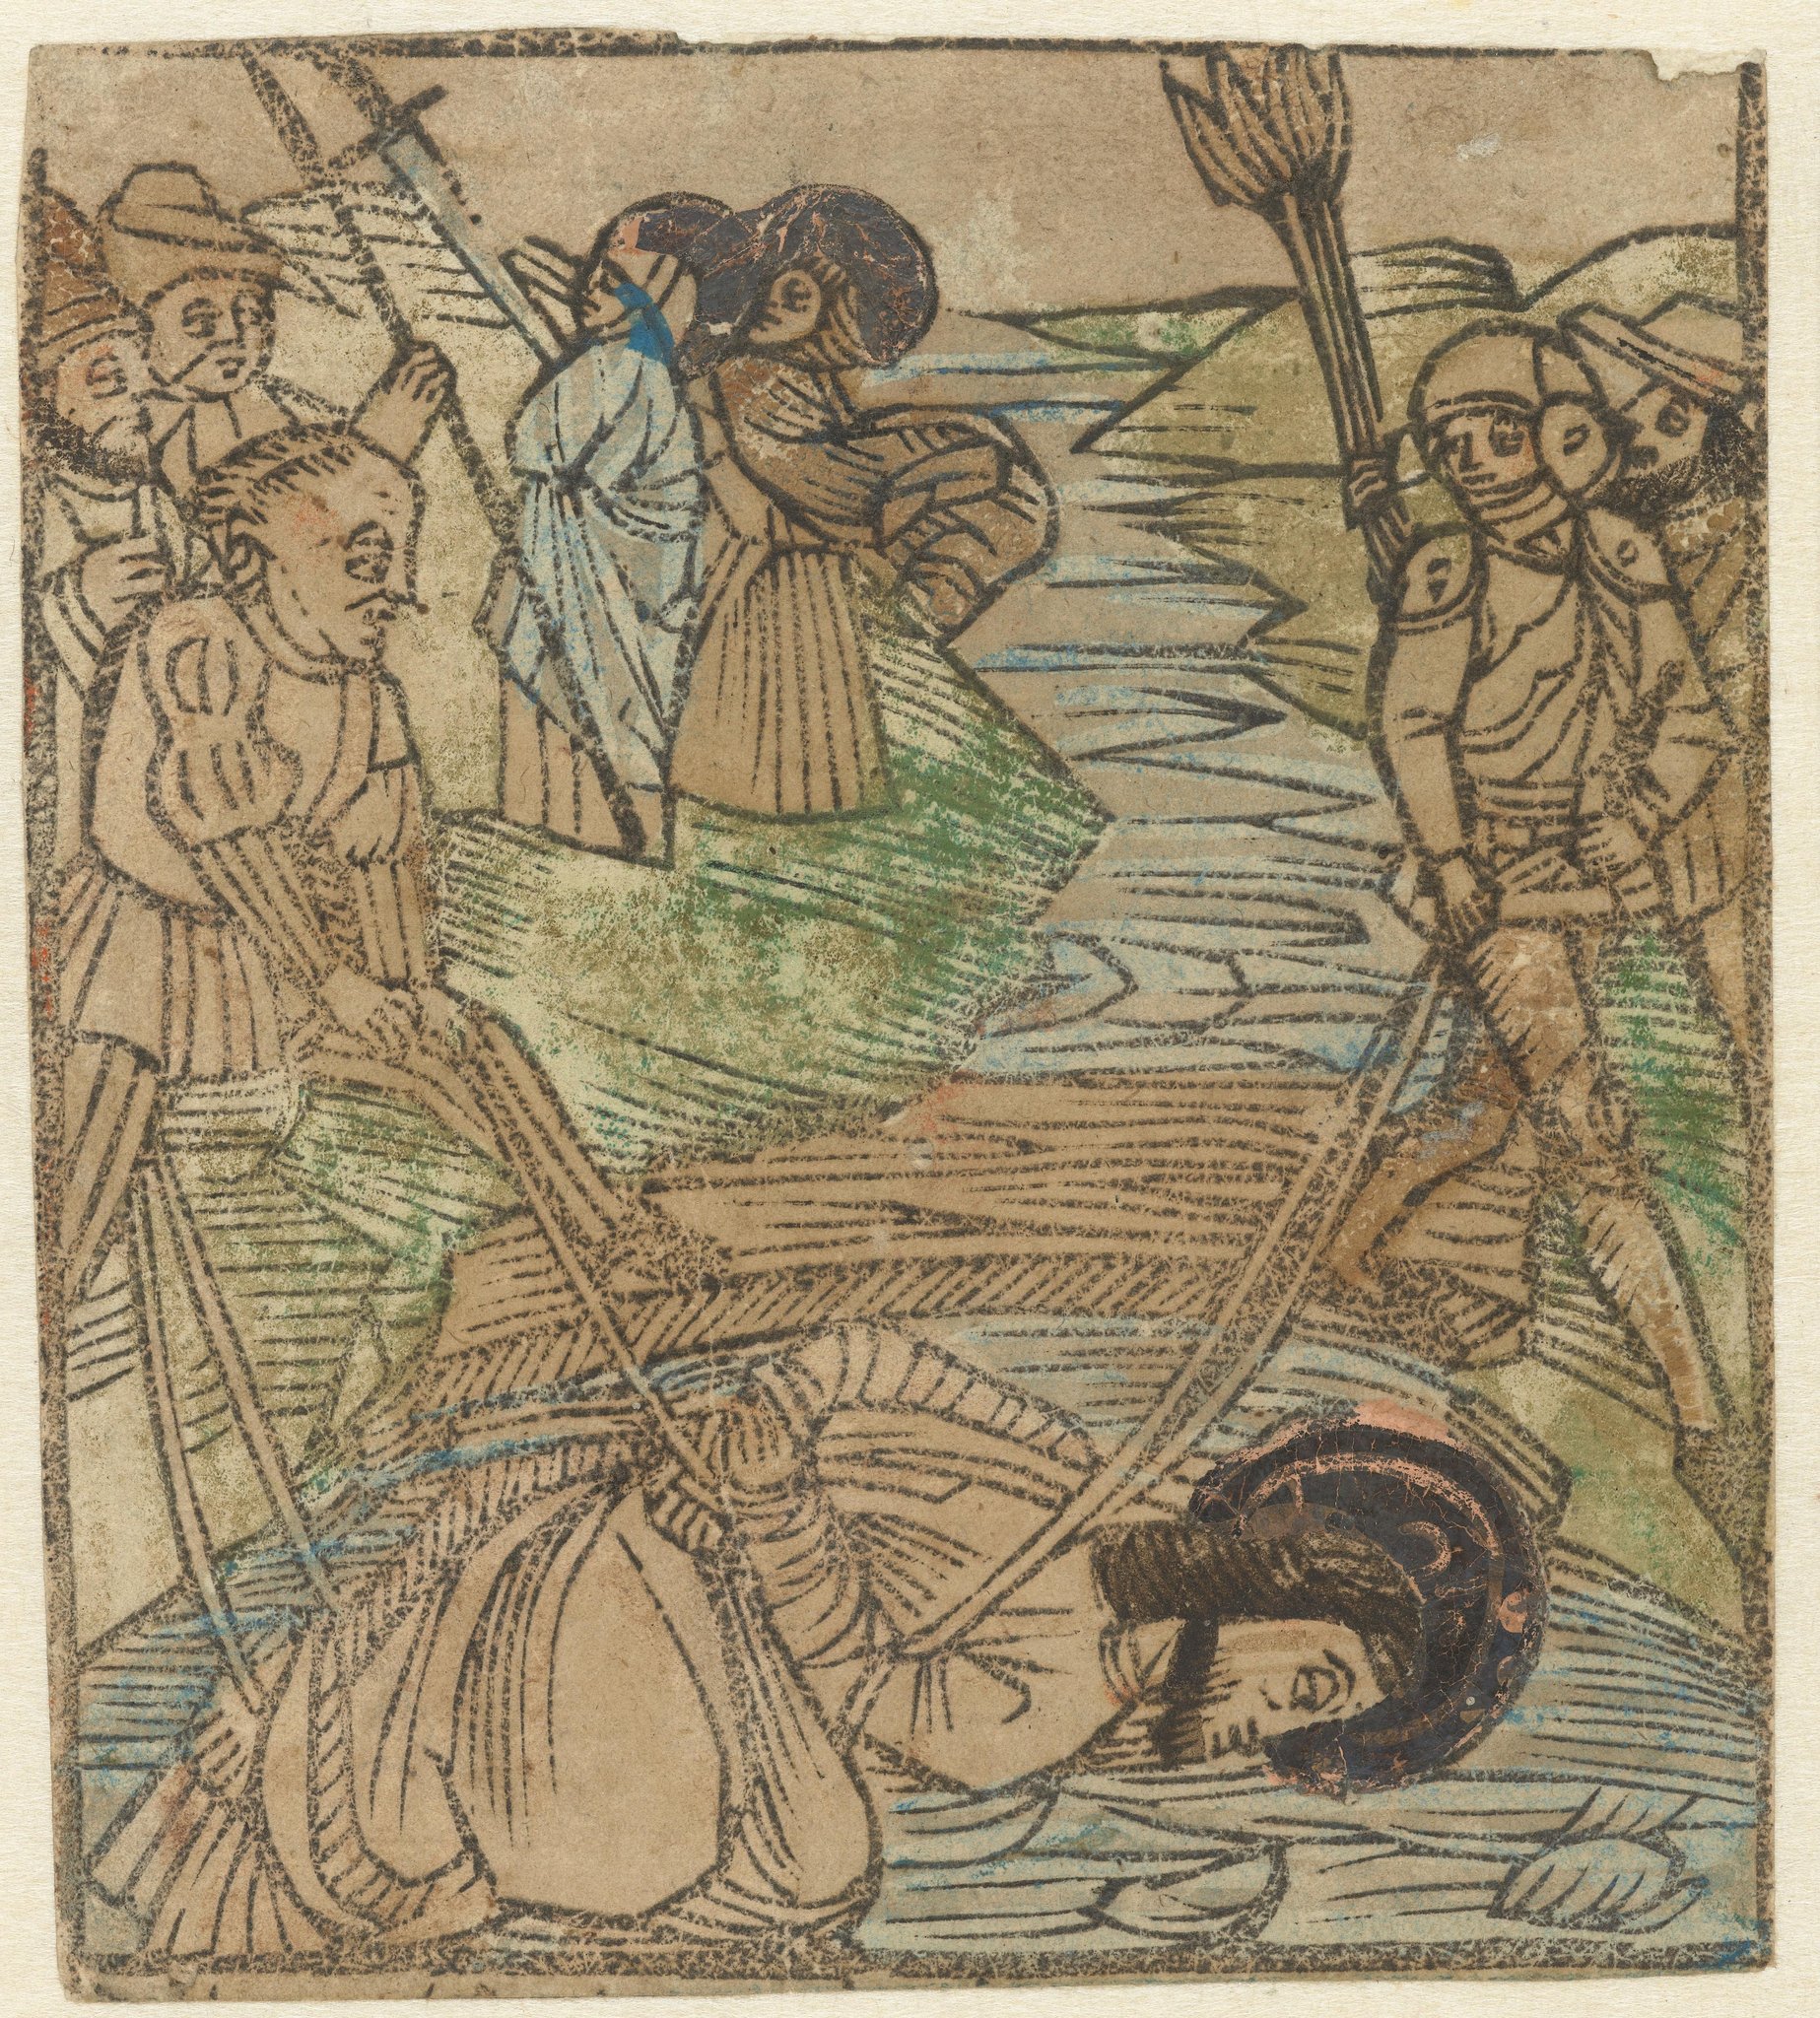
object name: print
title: De val van Christus in de beek Kedron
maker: Anonymous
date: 1480-1500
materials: paper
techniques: hand coloring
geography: low countries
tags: christ is dragged through the brook cedron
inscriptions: collector's mark: Lugt 2760, collector's mark: Lugt 2166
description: Christus, op de voorgrond, wordt geketend in de beek van Cebron geworpen door krijgslieden.